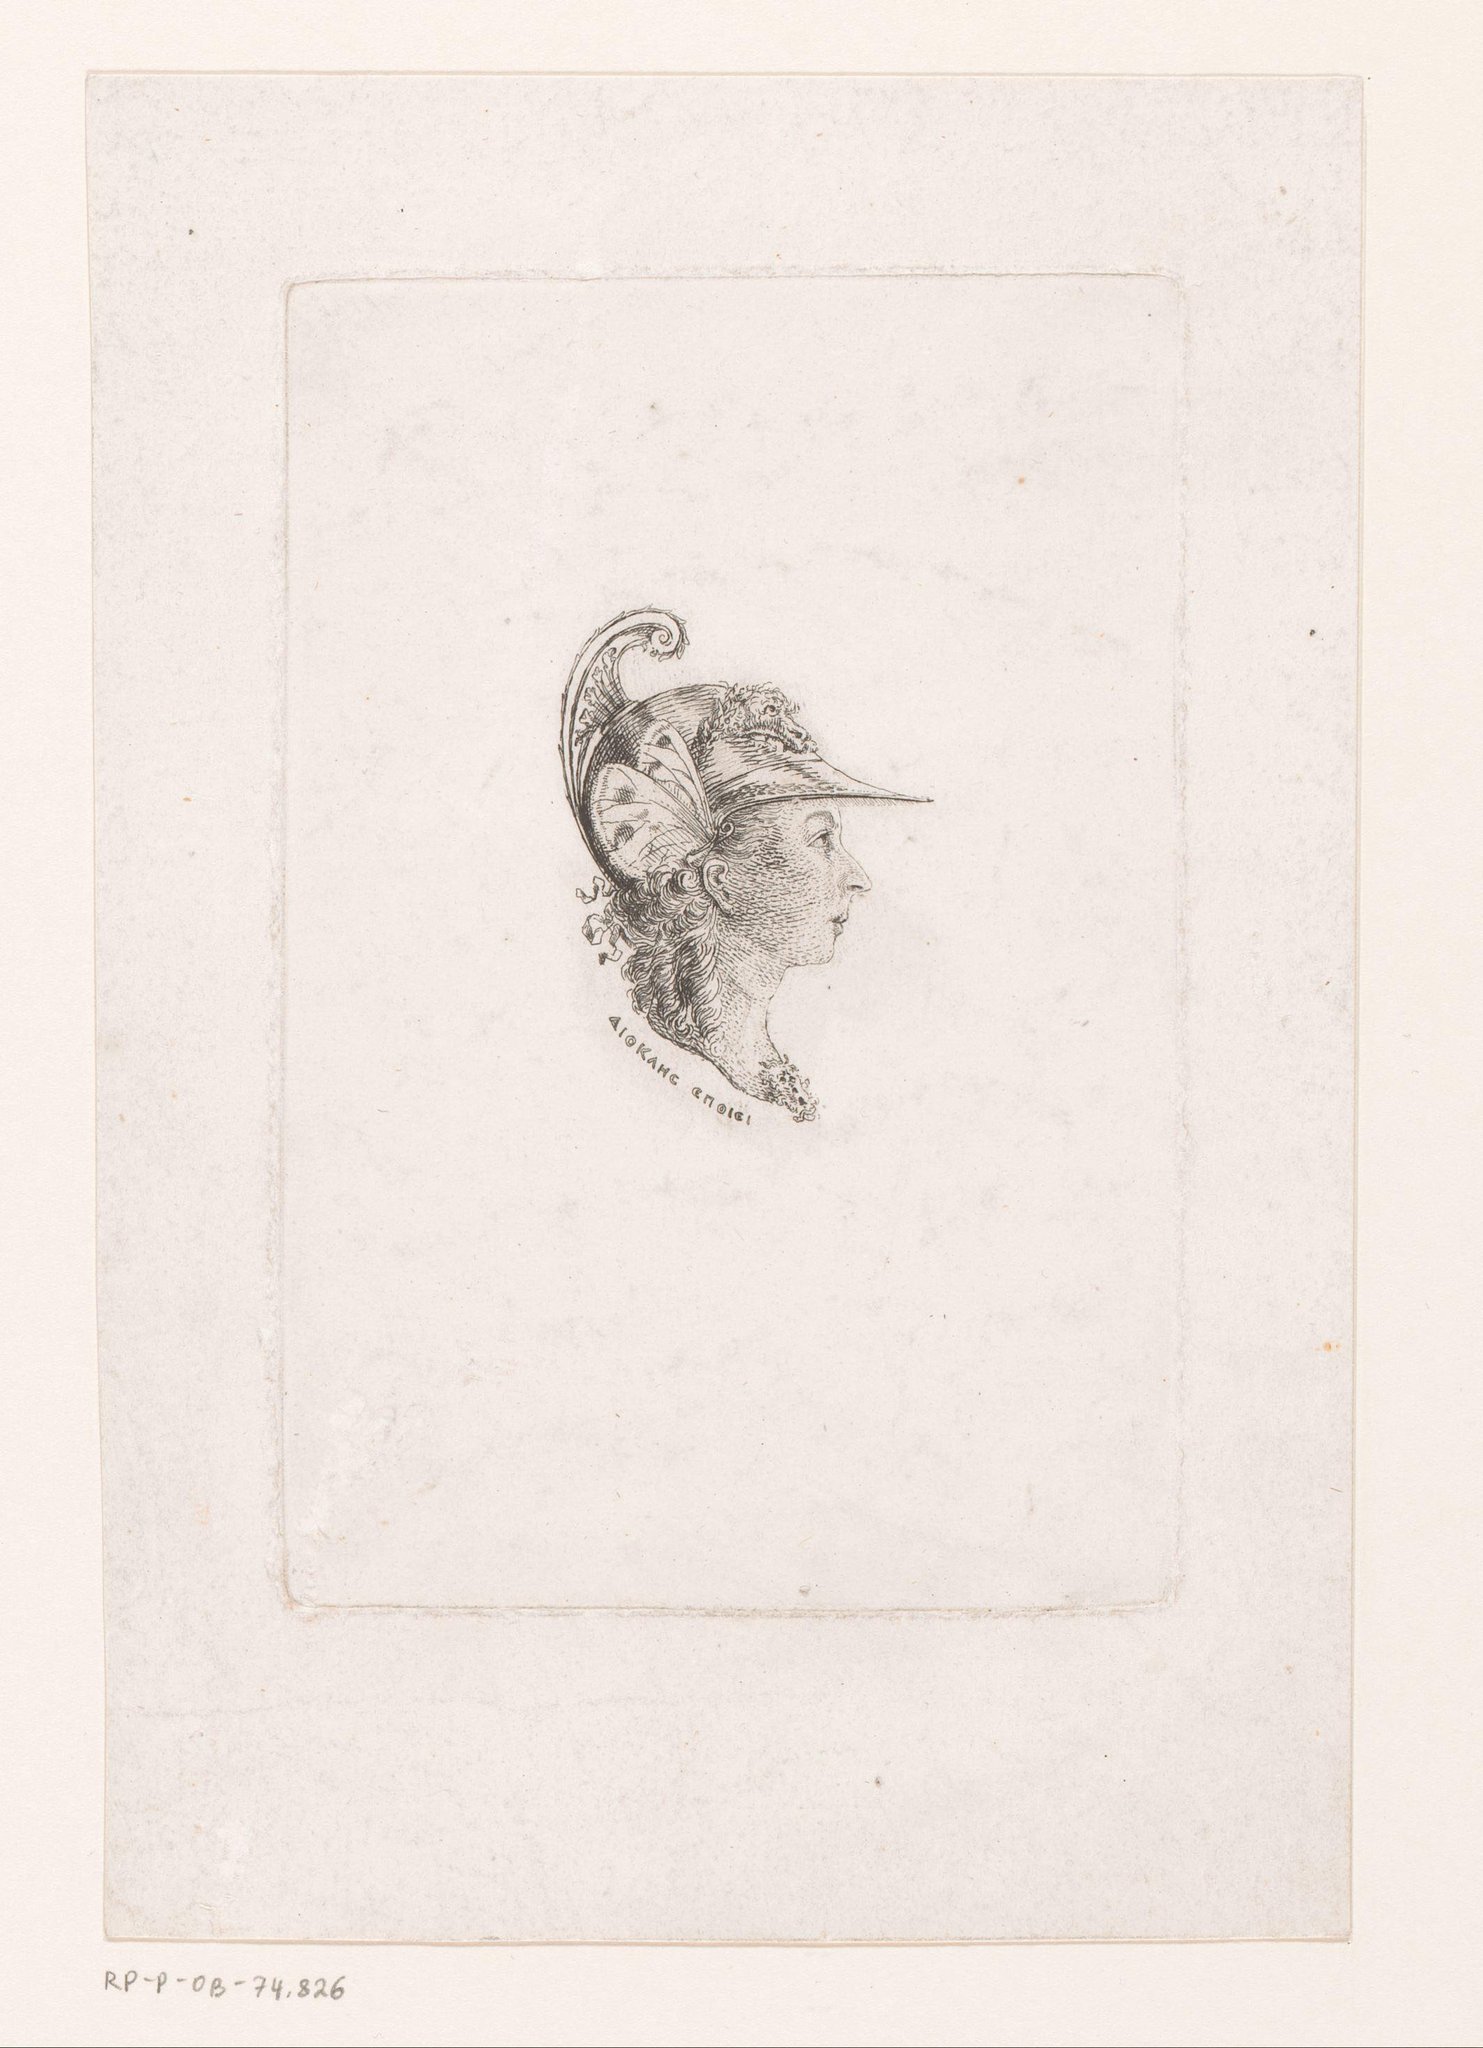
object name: print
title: Hoofd van een gehelmde man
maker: Anonymous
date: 1800-1899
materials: paper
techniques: etching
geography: france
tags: helmet, historical persons not known by name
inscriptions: collector's mark: Lugt 2228